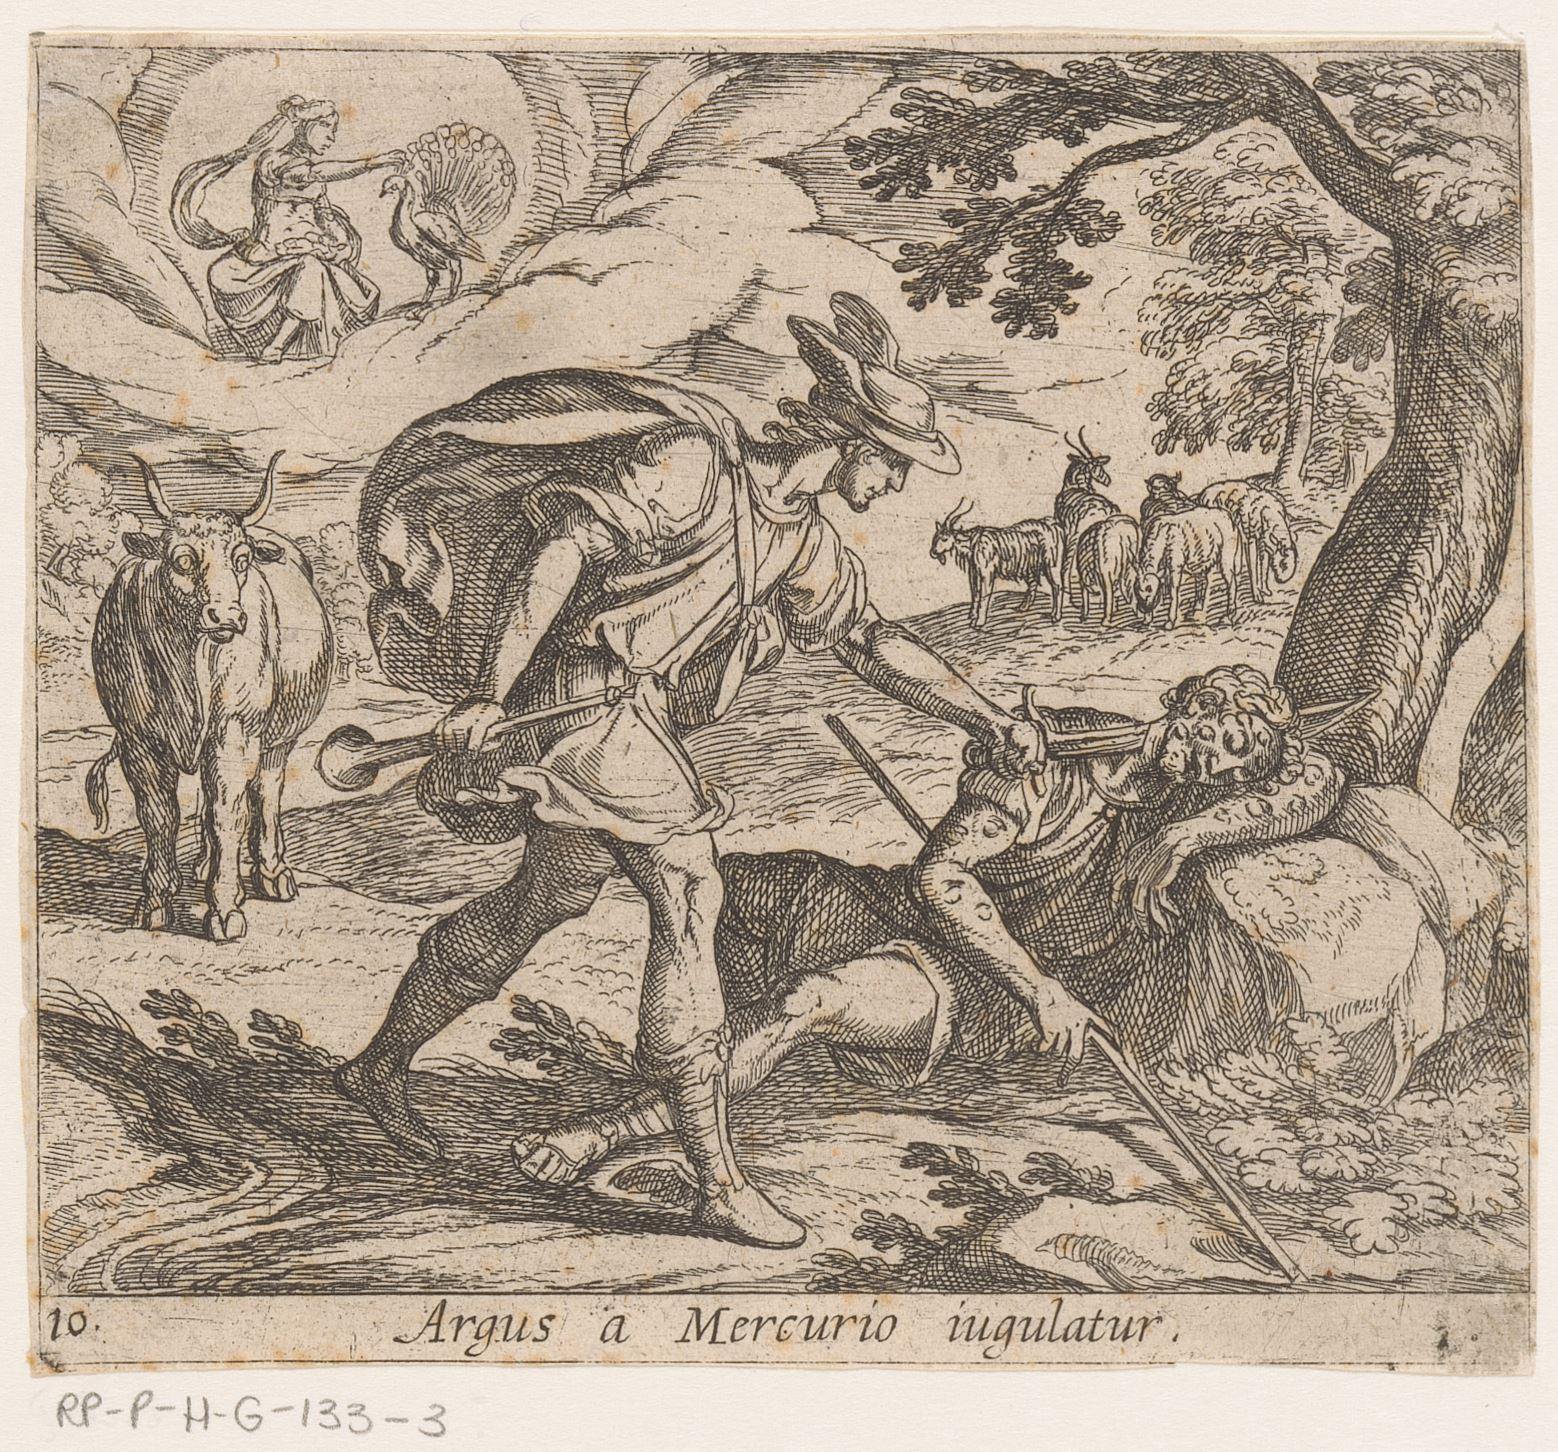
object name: print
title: Argus a Mercurio iugulatur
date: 1606-1638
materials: paper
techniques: etching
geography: amsterdam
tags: (story of) mercury (hermes), mercury beheads argus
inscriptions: collector's mark: ‘Hinloopen’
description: Mercurius snijdt met zijn zwaard het hoofd van de slapende Argus af. Juno zit met een pauw op wolken. In het landschap staan een os en een kudde bokken en schapen. Titel in het Latijn in ondermarge.